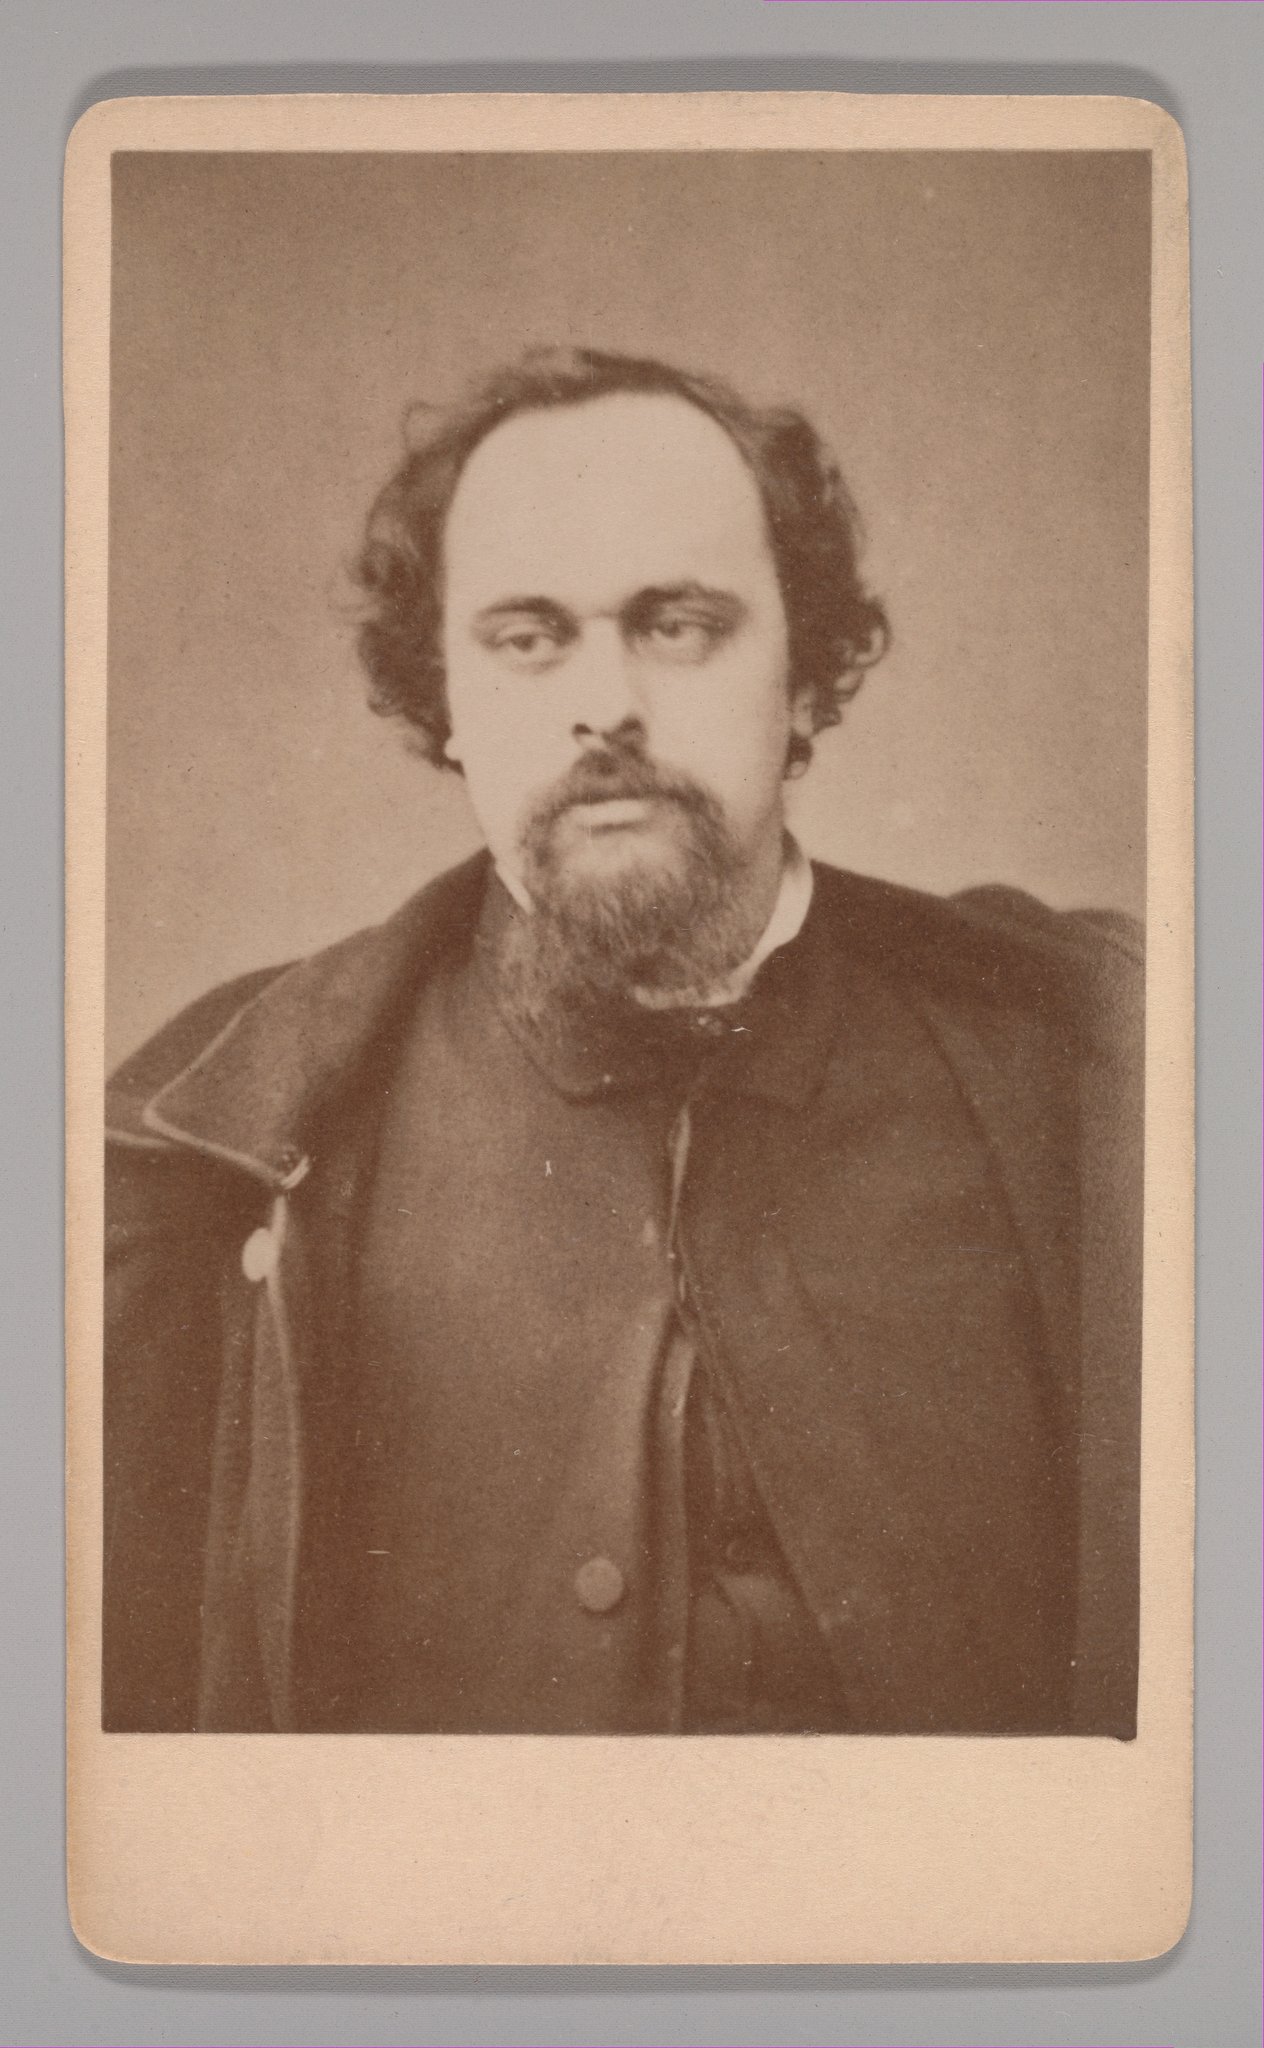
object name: carte de visite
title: [Dante Gabriel Rossetti]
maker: Anonymous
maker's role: artist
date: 1860-1869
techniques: albumen silver print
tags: men,portraits